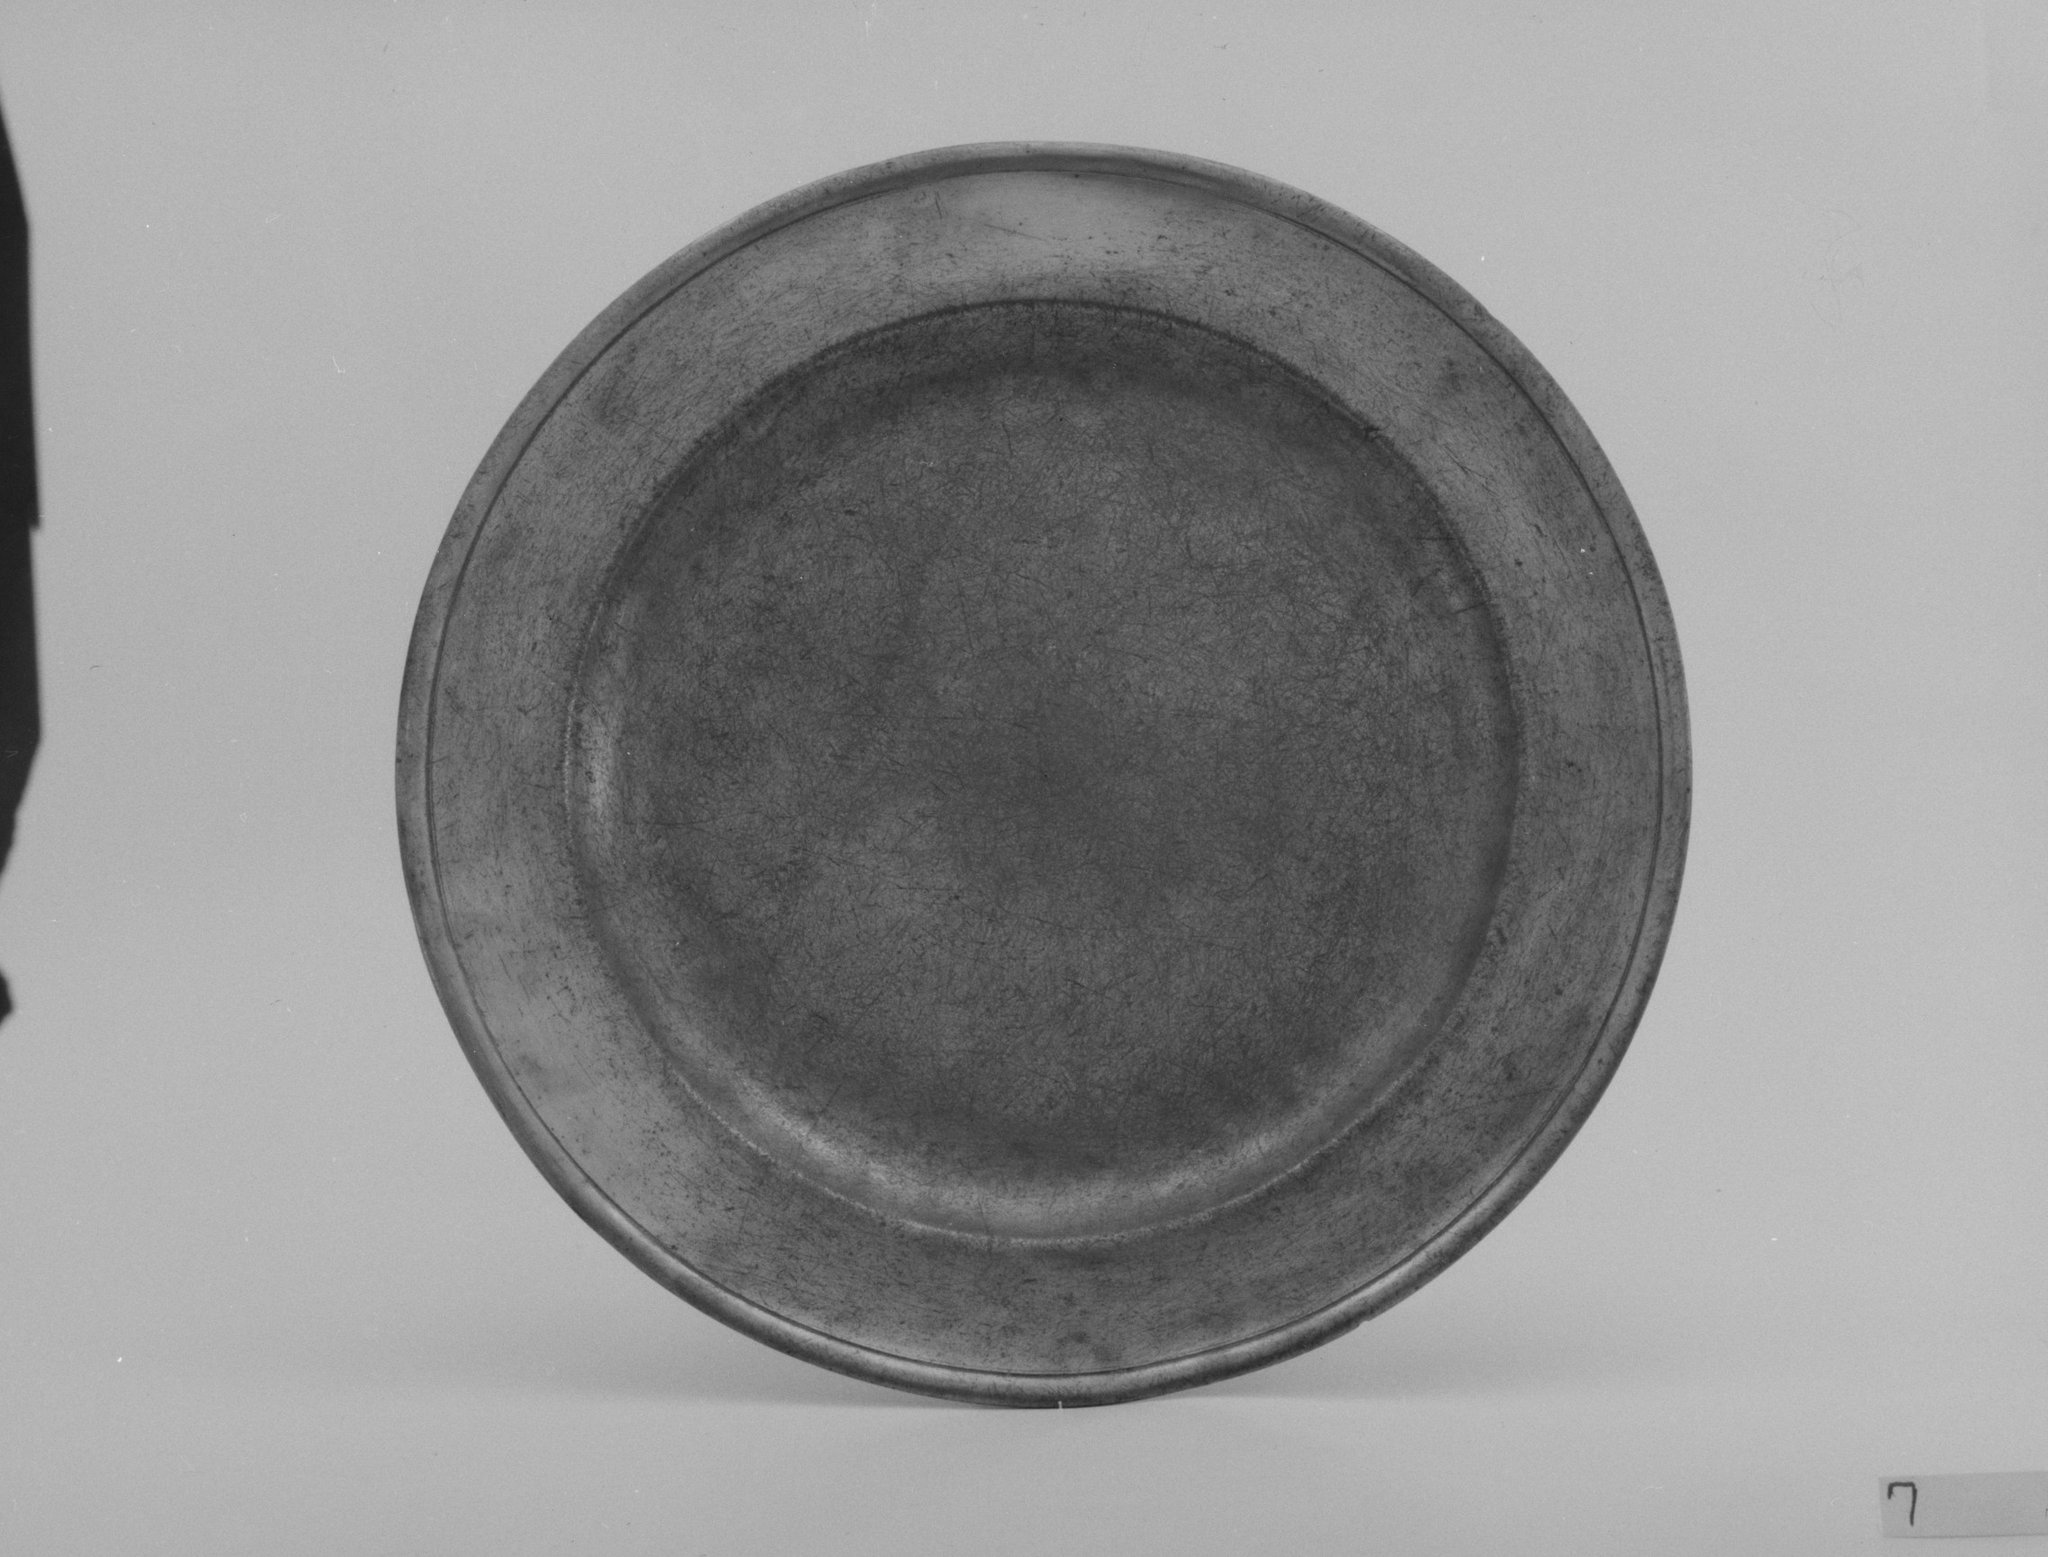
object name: dish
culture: american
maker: frederick bassett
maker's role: maker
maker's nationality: american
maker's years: 1740-1800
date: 1761-1781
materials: pewter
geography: united states